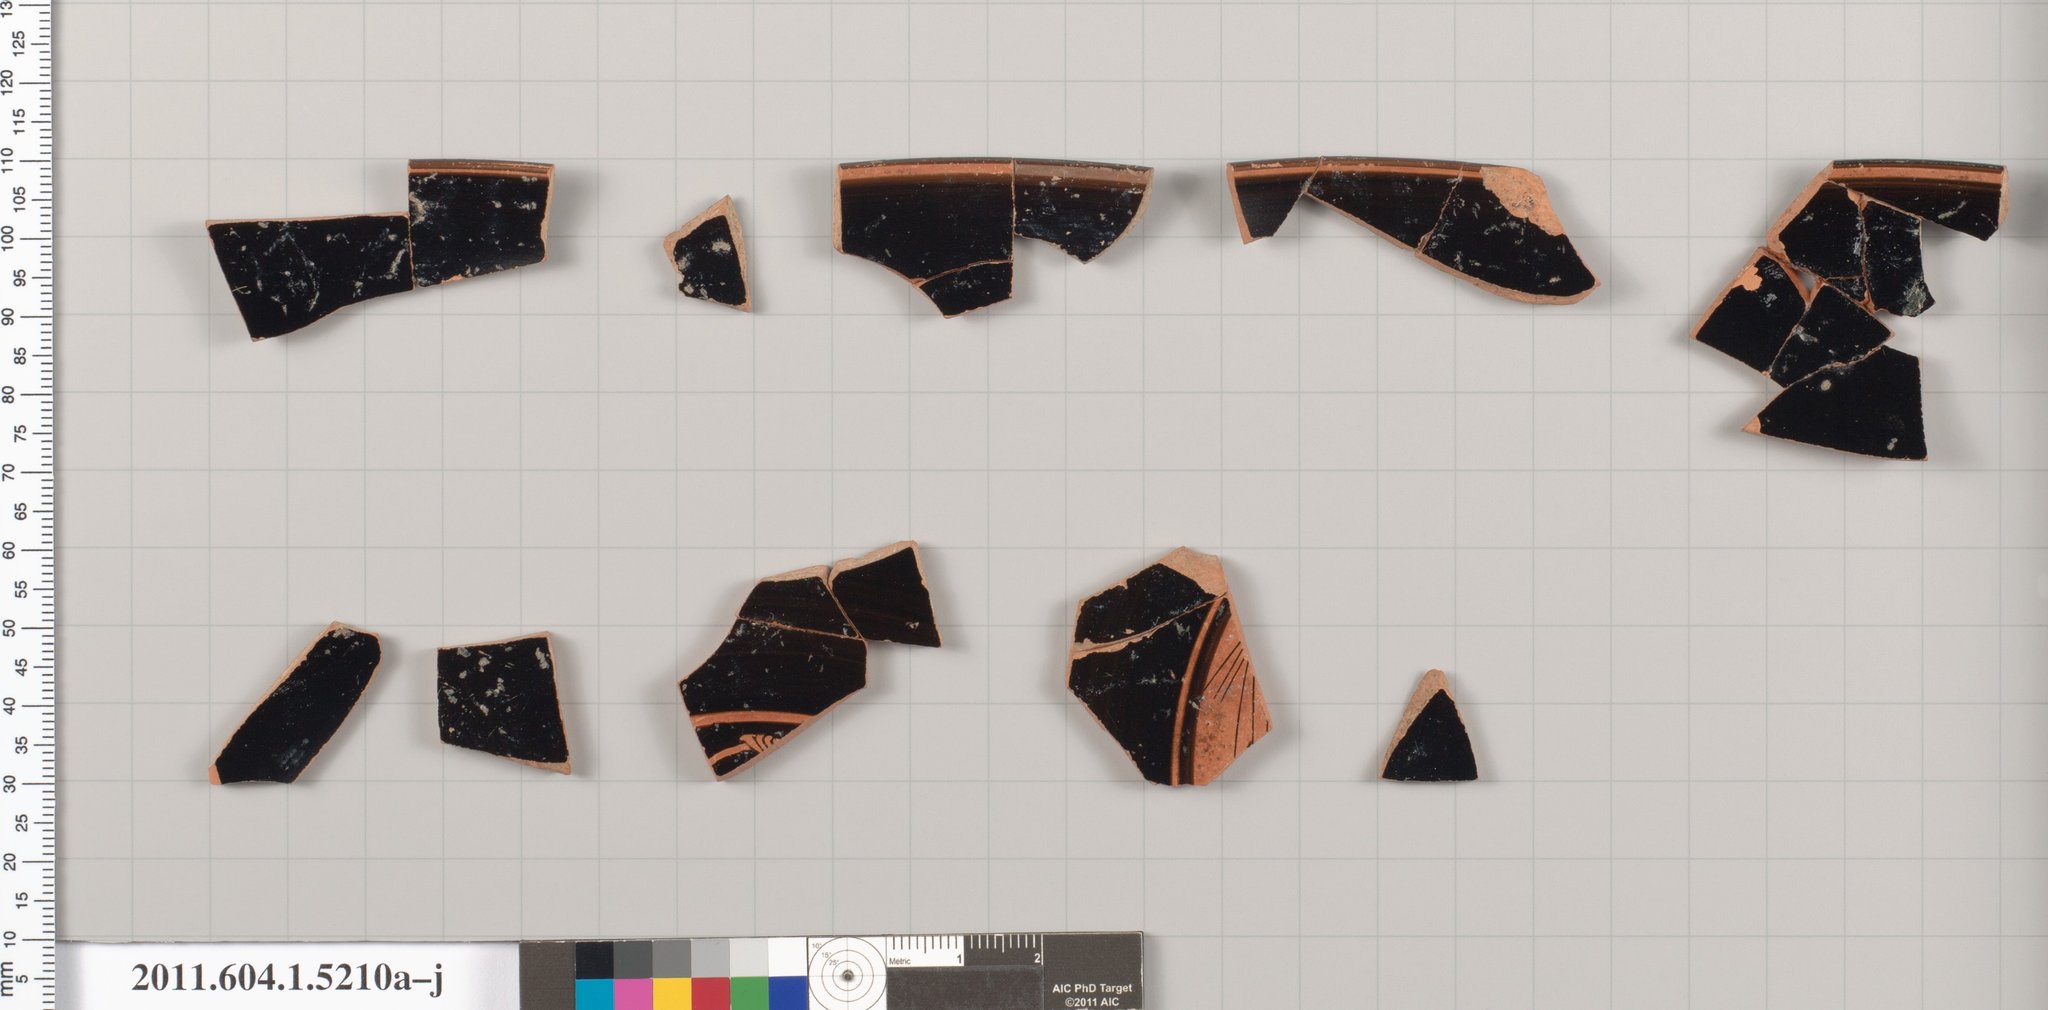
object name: kylix fragment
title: Terracotta fragments of a kylix (drinking cup)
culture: greek, attic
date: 520-500 BCE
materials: terracotta